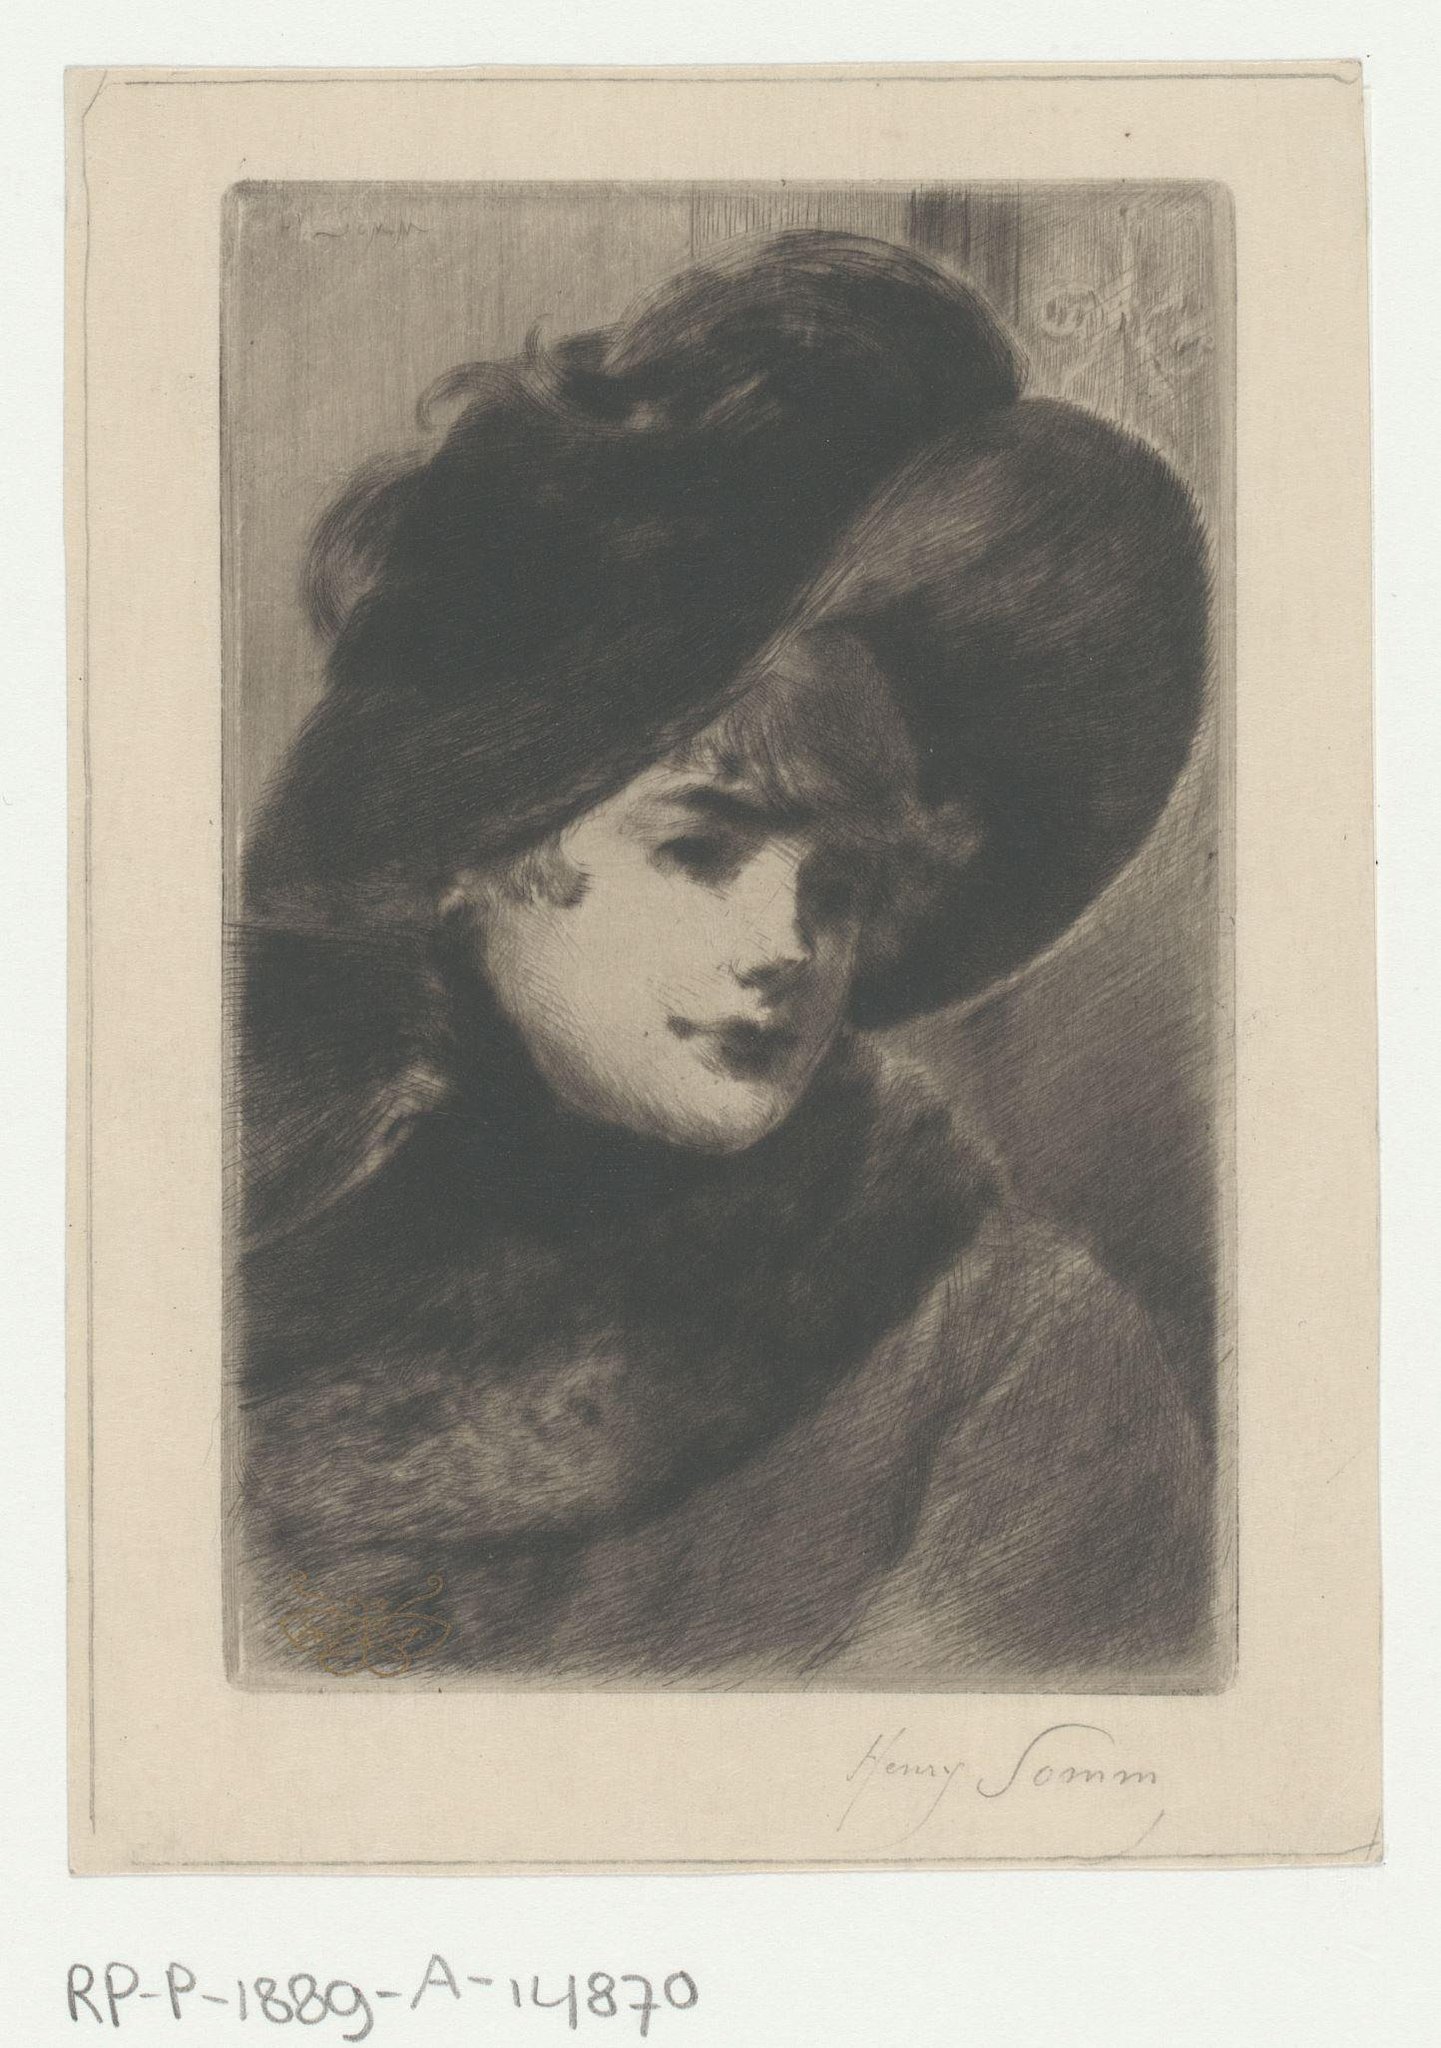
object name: print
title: Parisienne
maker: henry somm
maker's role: print maker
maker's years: 1844-1907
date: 1854-1889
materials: paper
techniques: drypoint, intaglio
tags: adolescent, young woman, maiden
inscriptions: collector's mark: Lugt 2228, collector's mark: Lugt 1371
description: Exemplaar bij Van Gogh Museum, inv.nr. p0124V1970, getiteld 'Parisienne'.